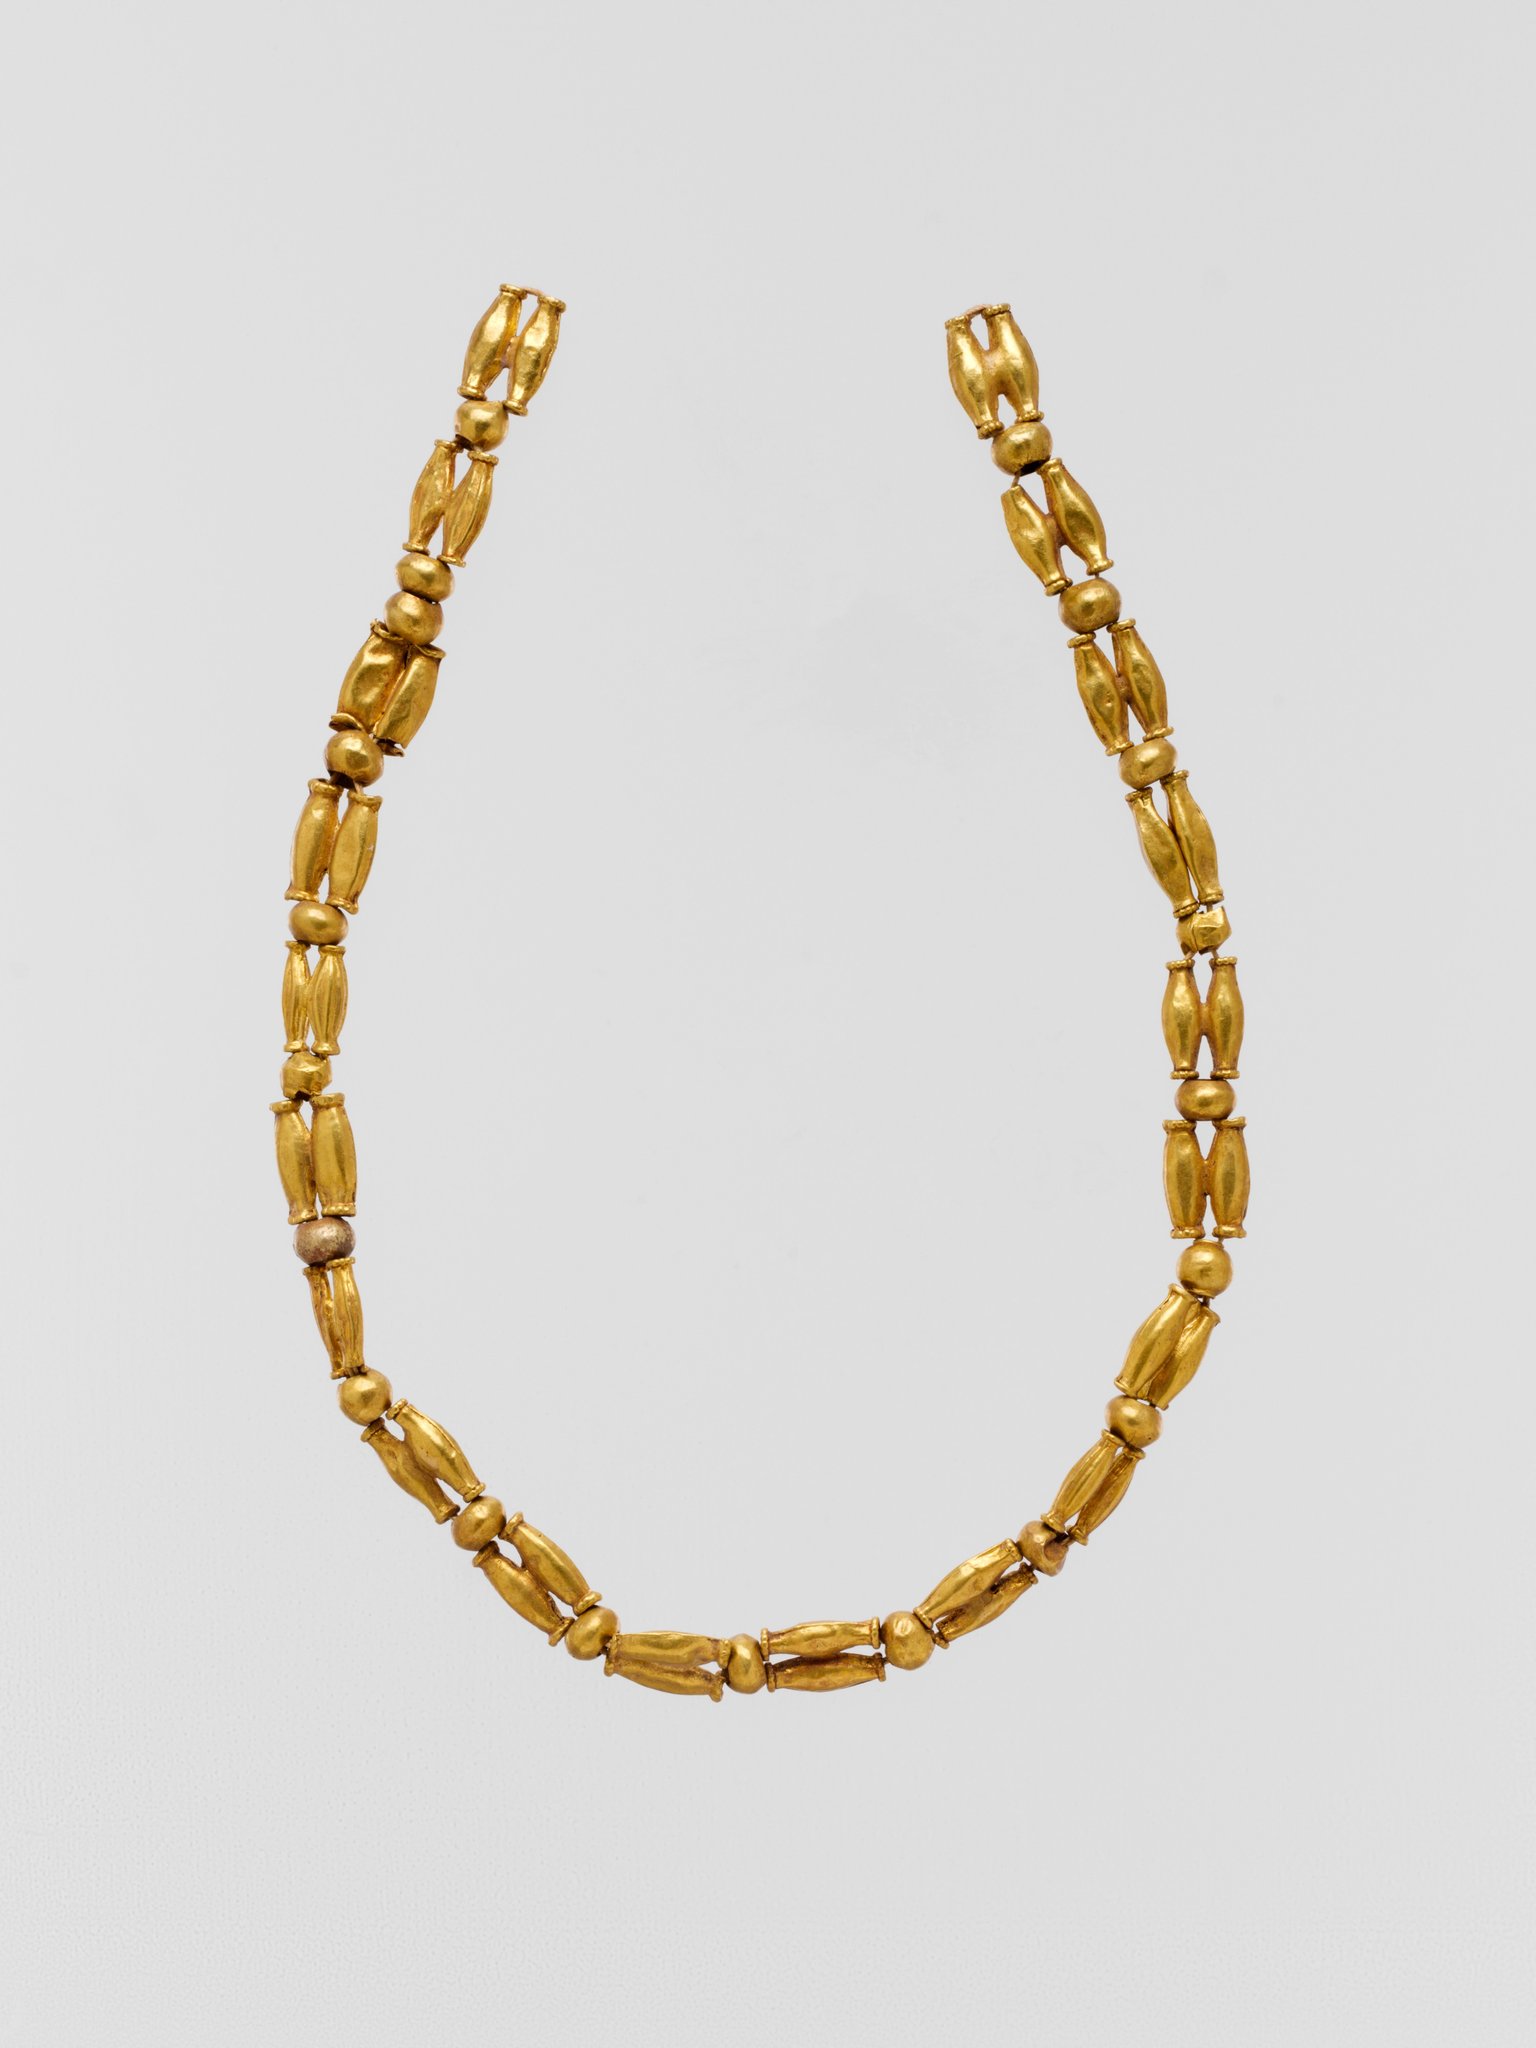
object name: bead, spindle, with spherical control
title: Gold beads, perhaps from a necklace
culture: cypriot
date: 600-501 BCE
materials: gold